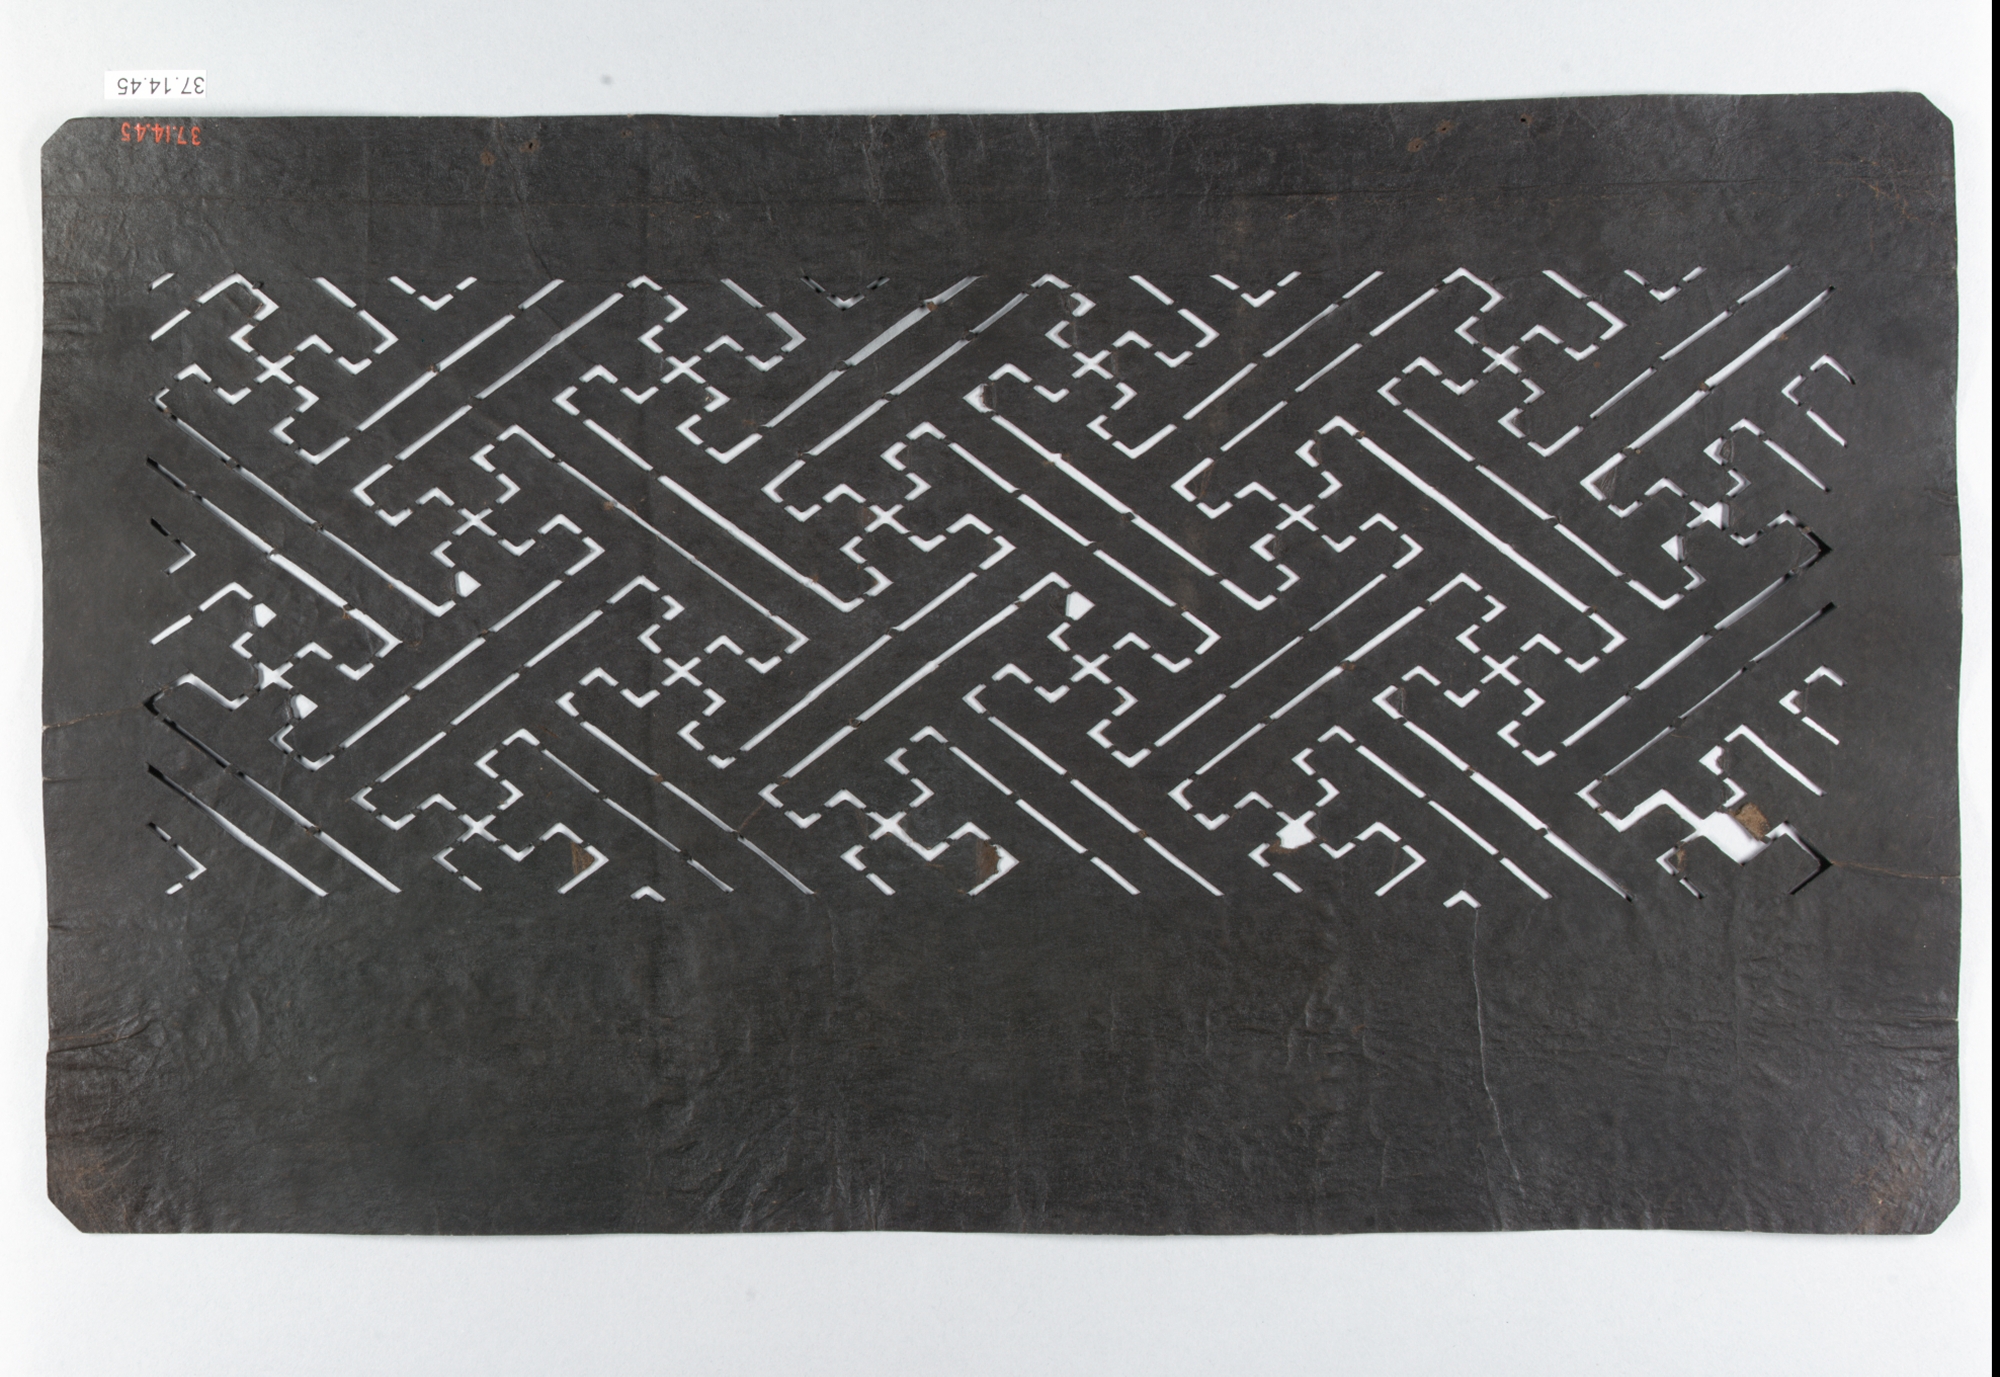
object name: stencil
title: Stencil with Continuous Fret Pattern (sayagata)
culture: japanese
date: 1801-1900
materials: paper